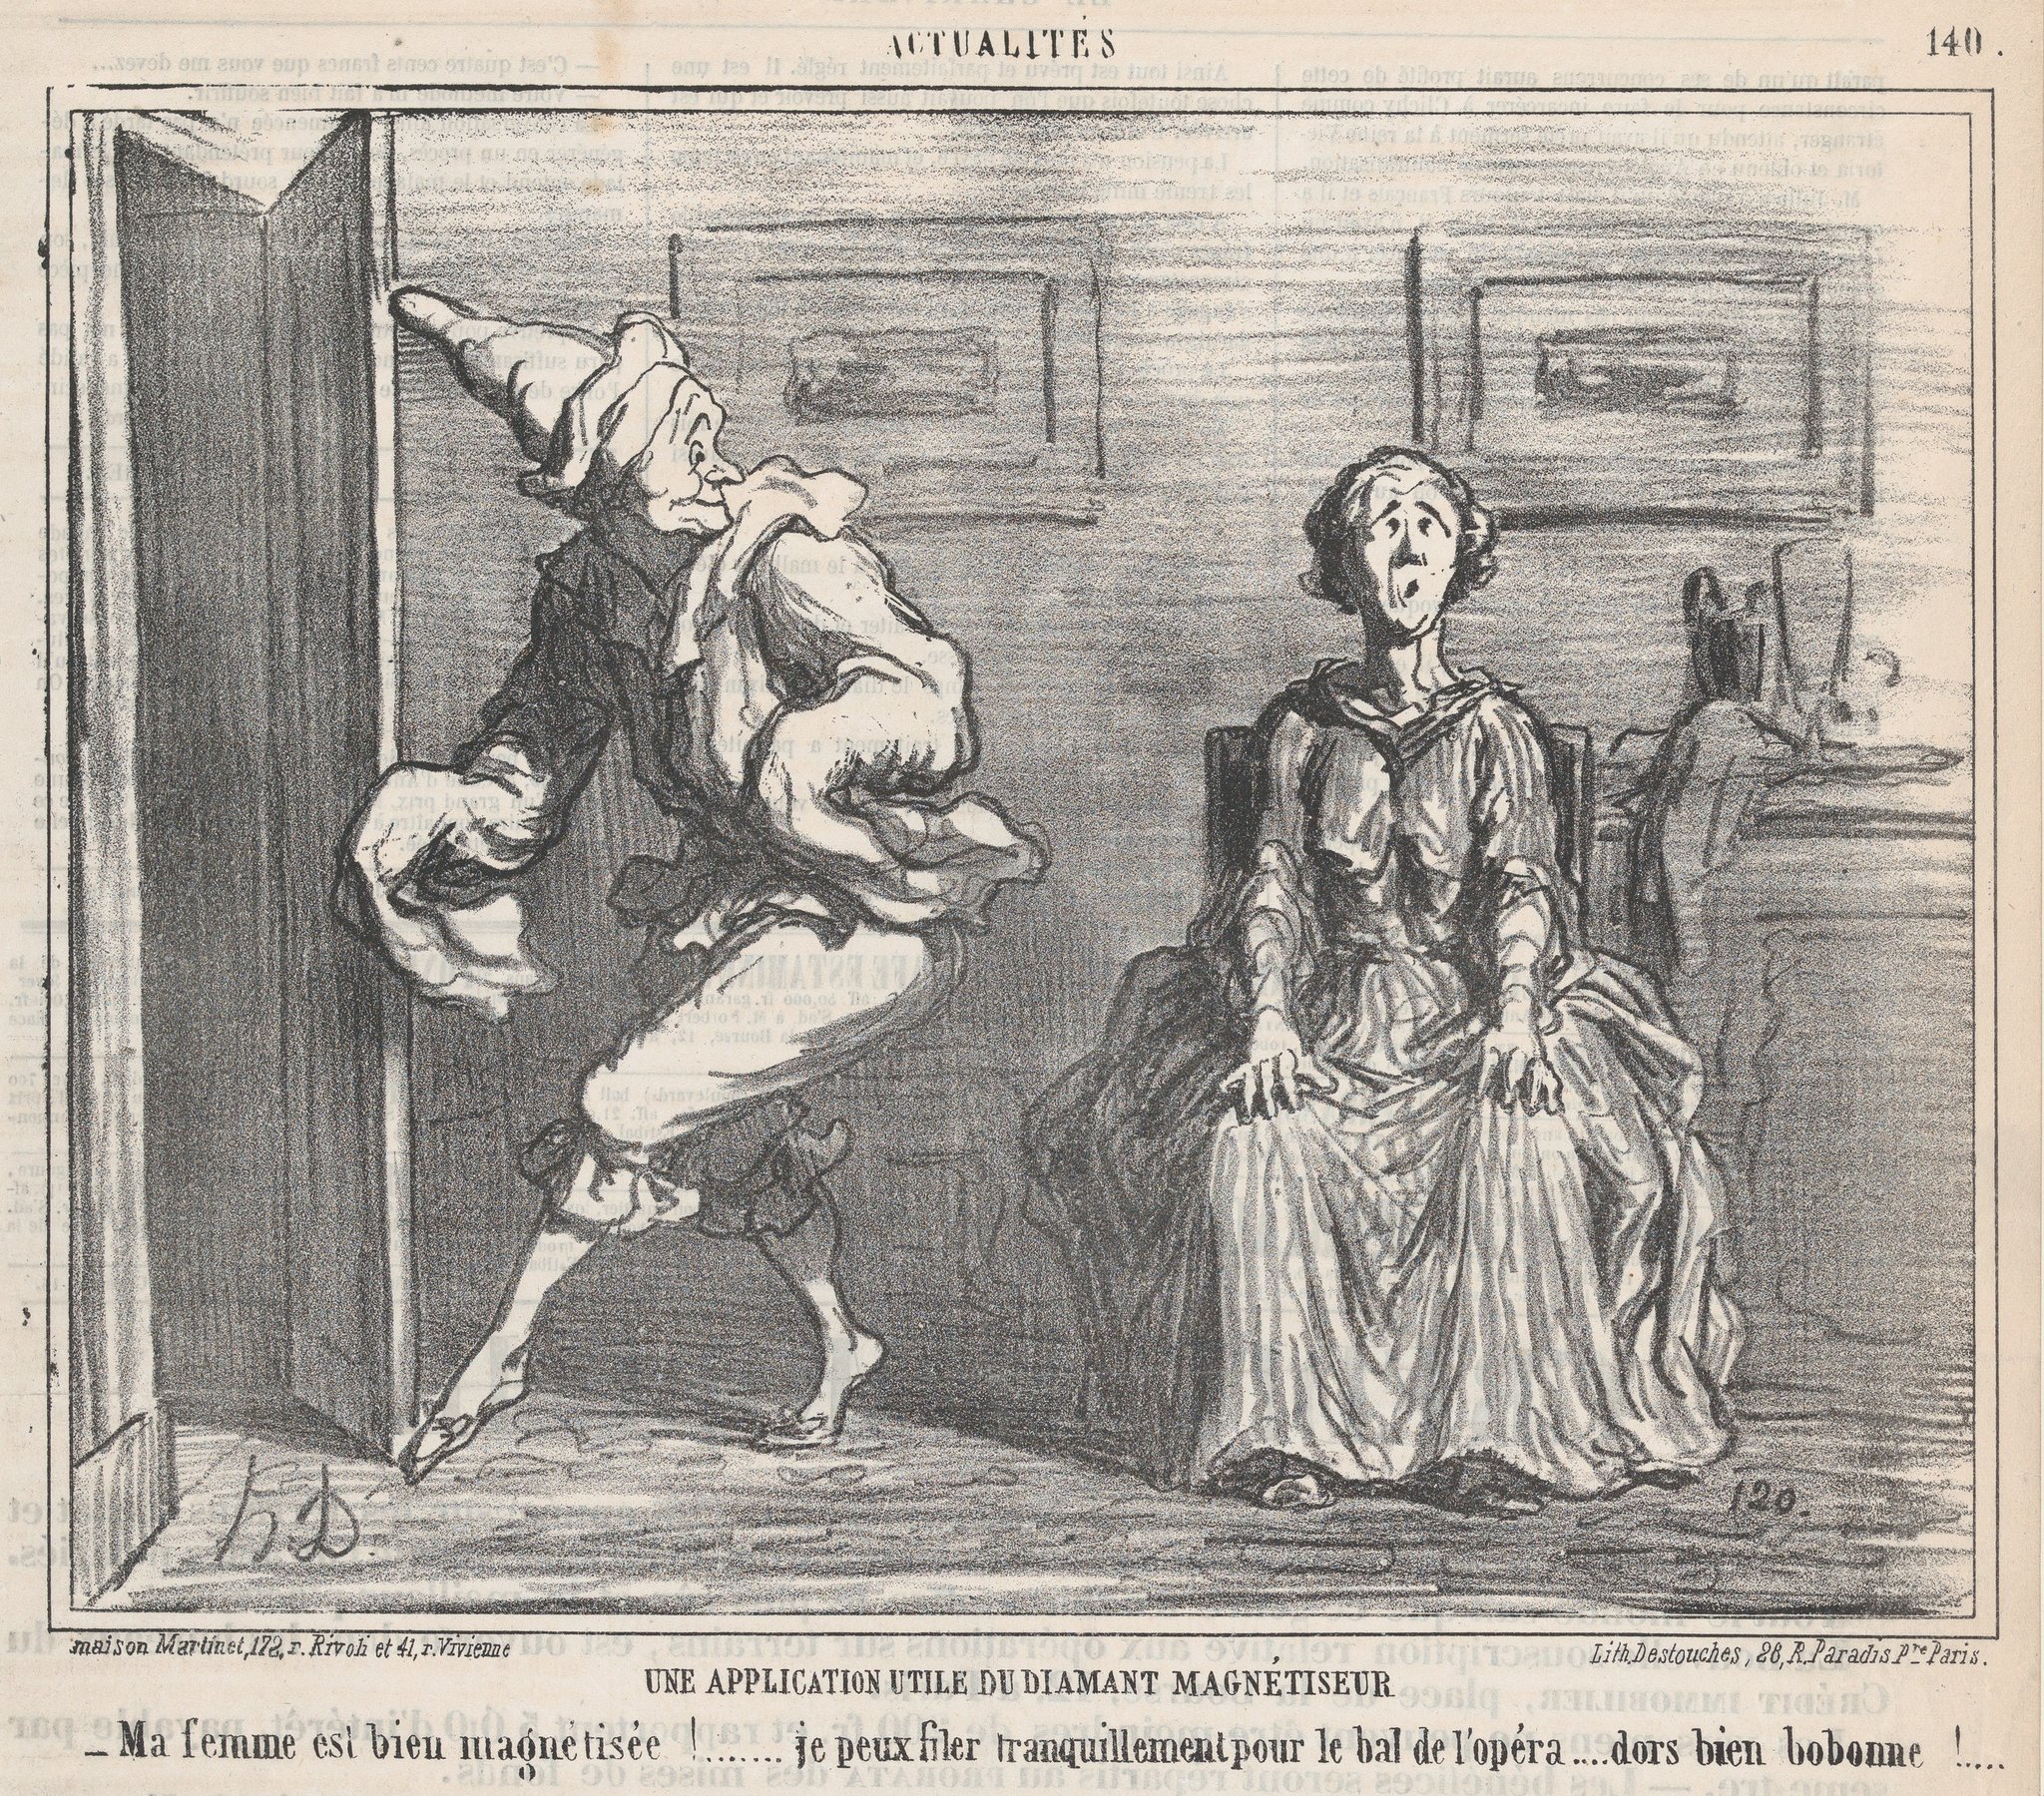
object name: print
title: Practical application for a diamond hypnotist, from 'News of the Day,' published in Le Charivari, January 24, 1860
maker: honoré daumier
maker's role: artist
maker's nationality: french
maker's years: 1808-1879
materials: paper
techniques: lithograph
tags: men,women